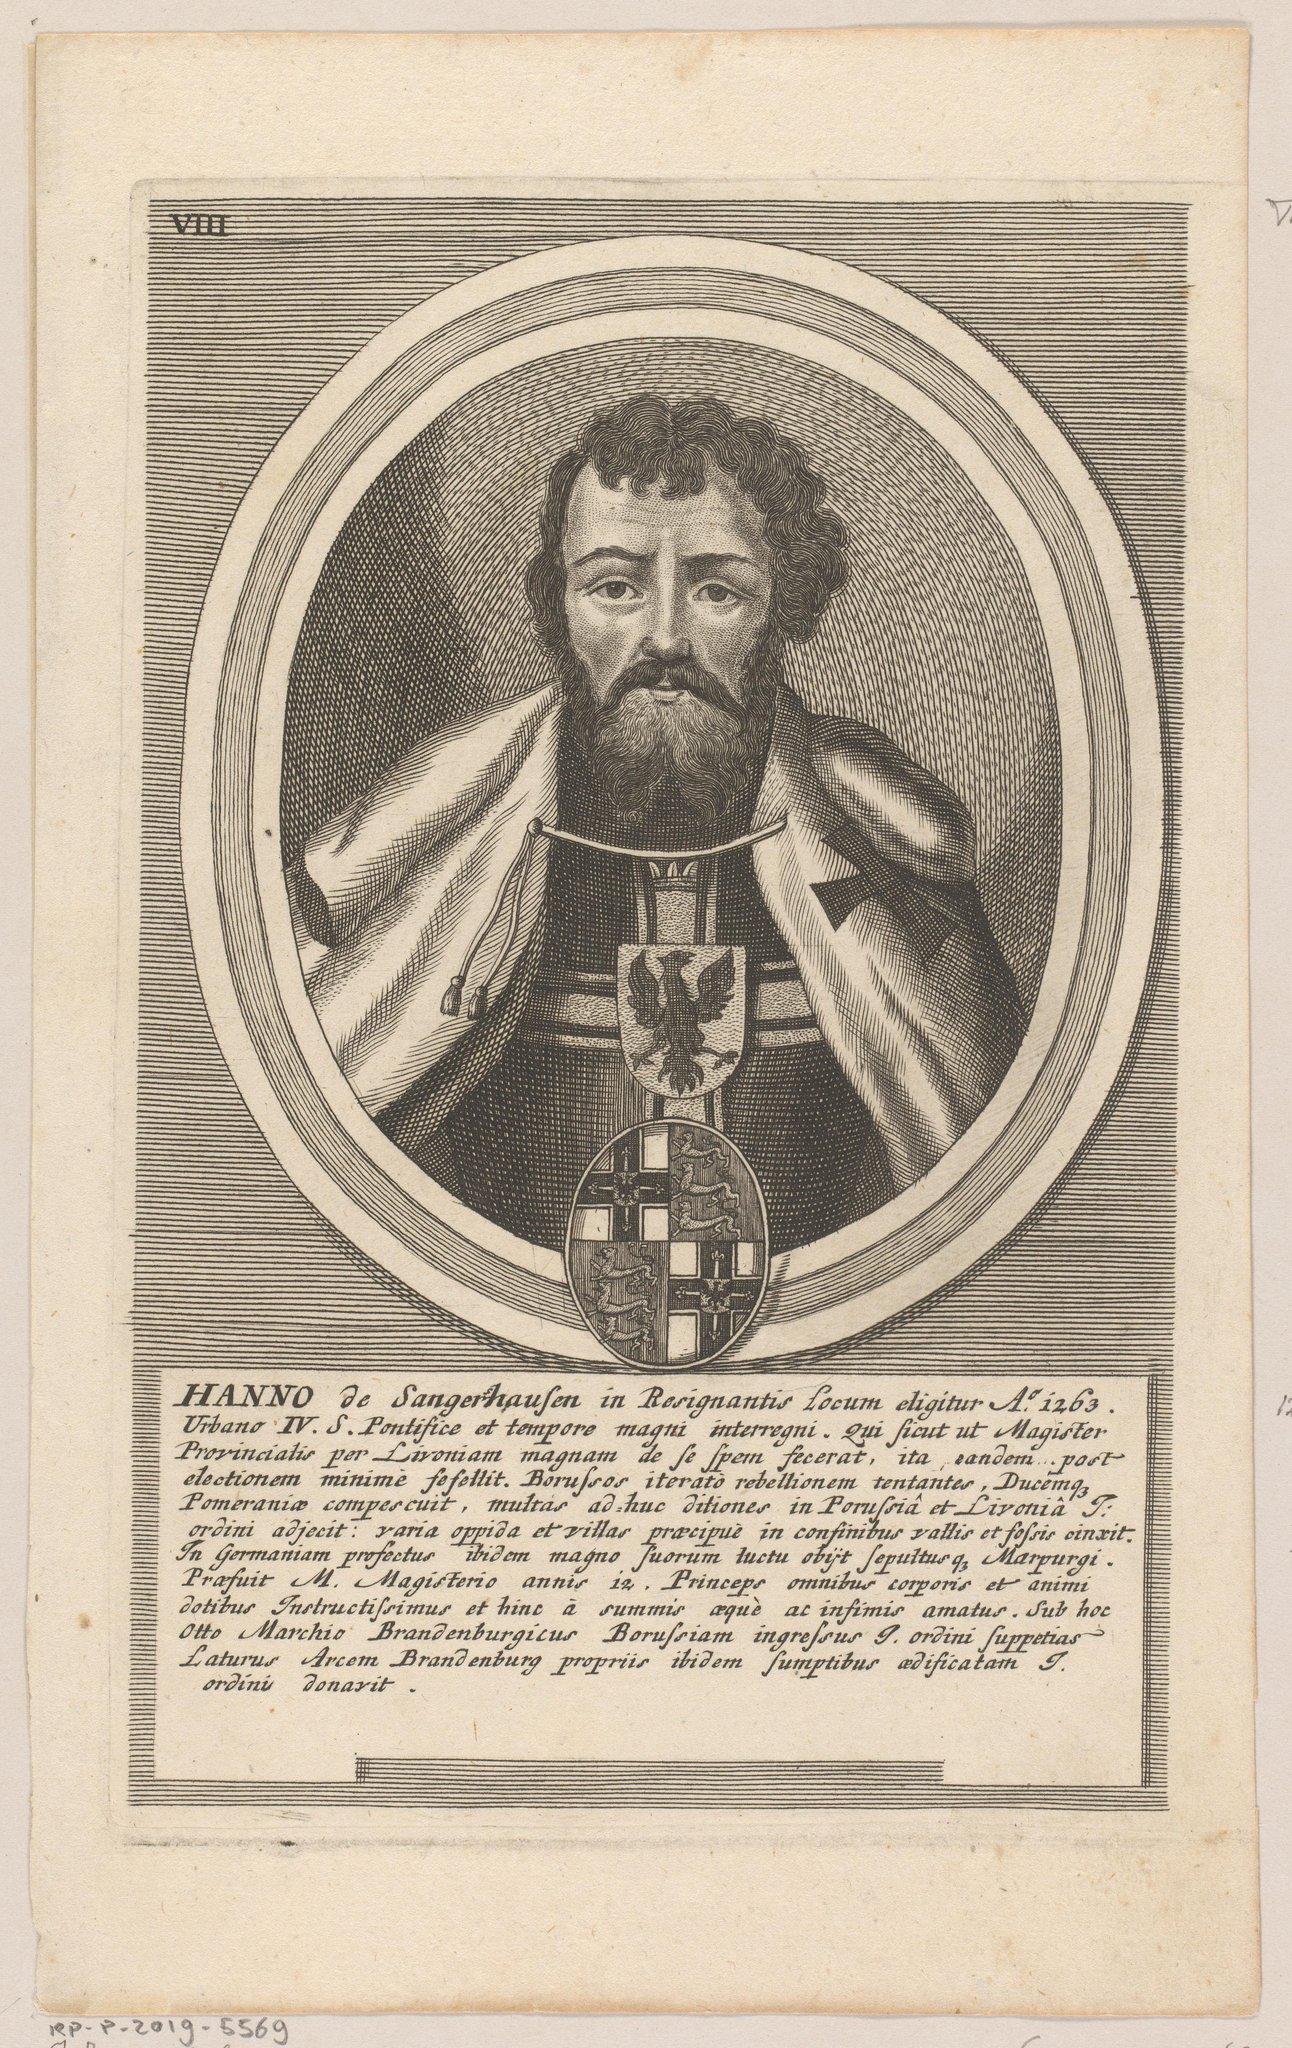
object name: print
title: Portret van Anno von Sangerhausen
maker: johann salver (i)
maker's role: print maker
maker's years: 1670-1738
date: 1720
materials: paper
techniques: engraving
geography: würzburg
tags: knighthood order: teutonic order - insignia of a knighthood order, e.g.: badge, chain (with name of order), historical persons, armorial bearing, heraldry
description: Prent uit: [Salver, Johann]. De origine, secundis et adversis successibus, nec non de statu moderno inclyti ordinis equestris hospitalis b.m.v. Teutonicorum in Jerusalem. Würzburg: Johann Salver, [ca. 1720].